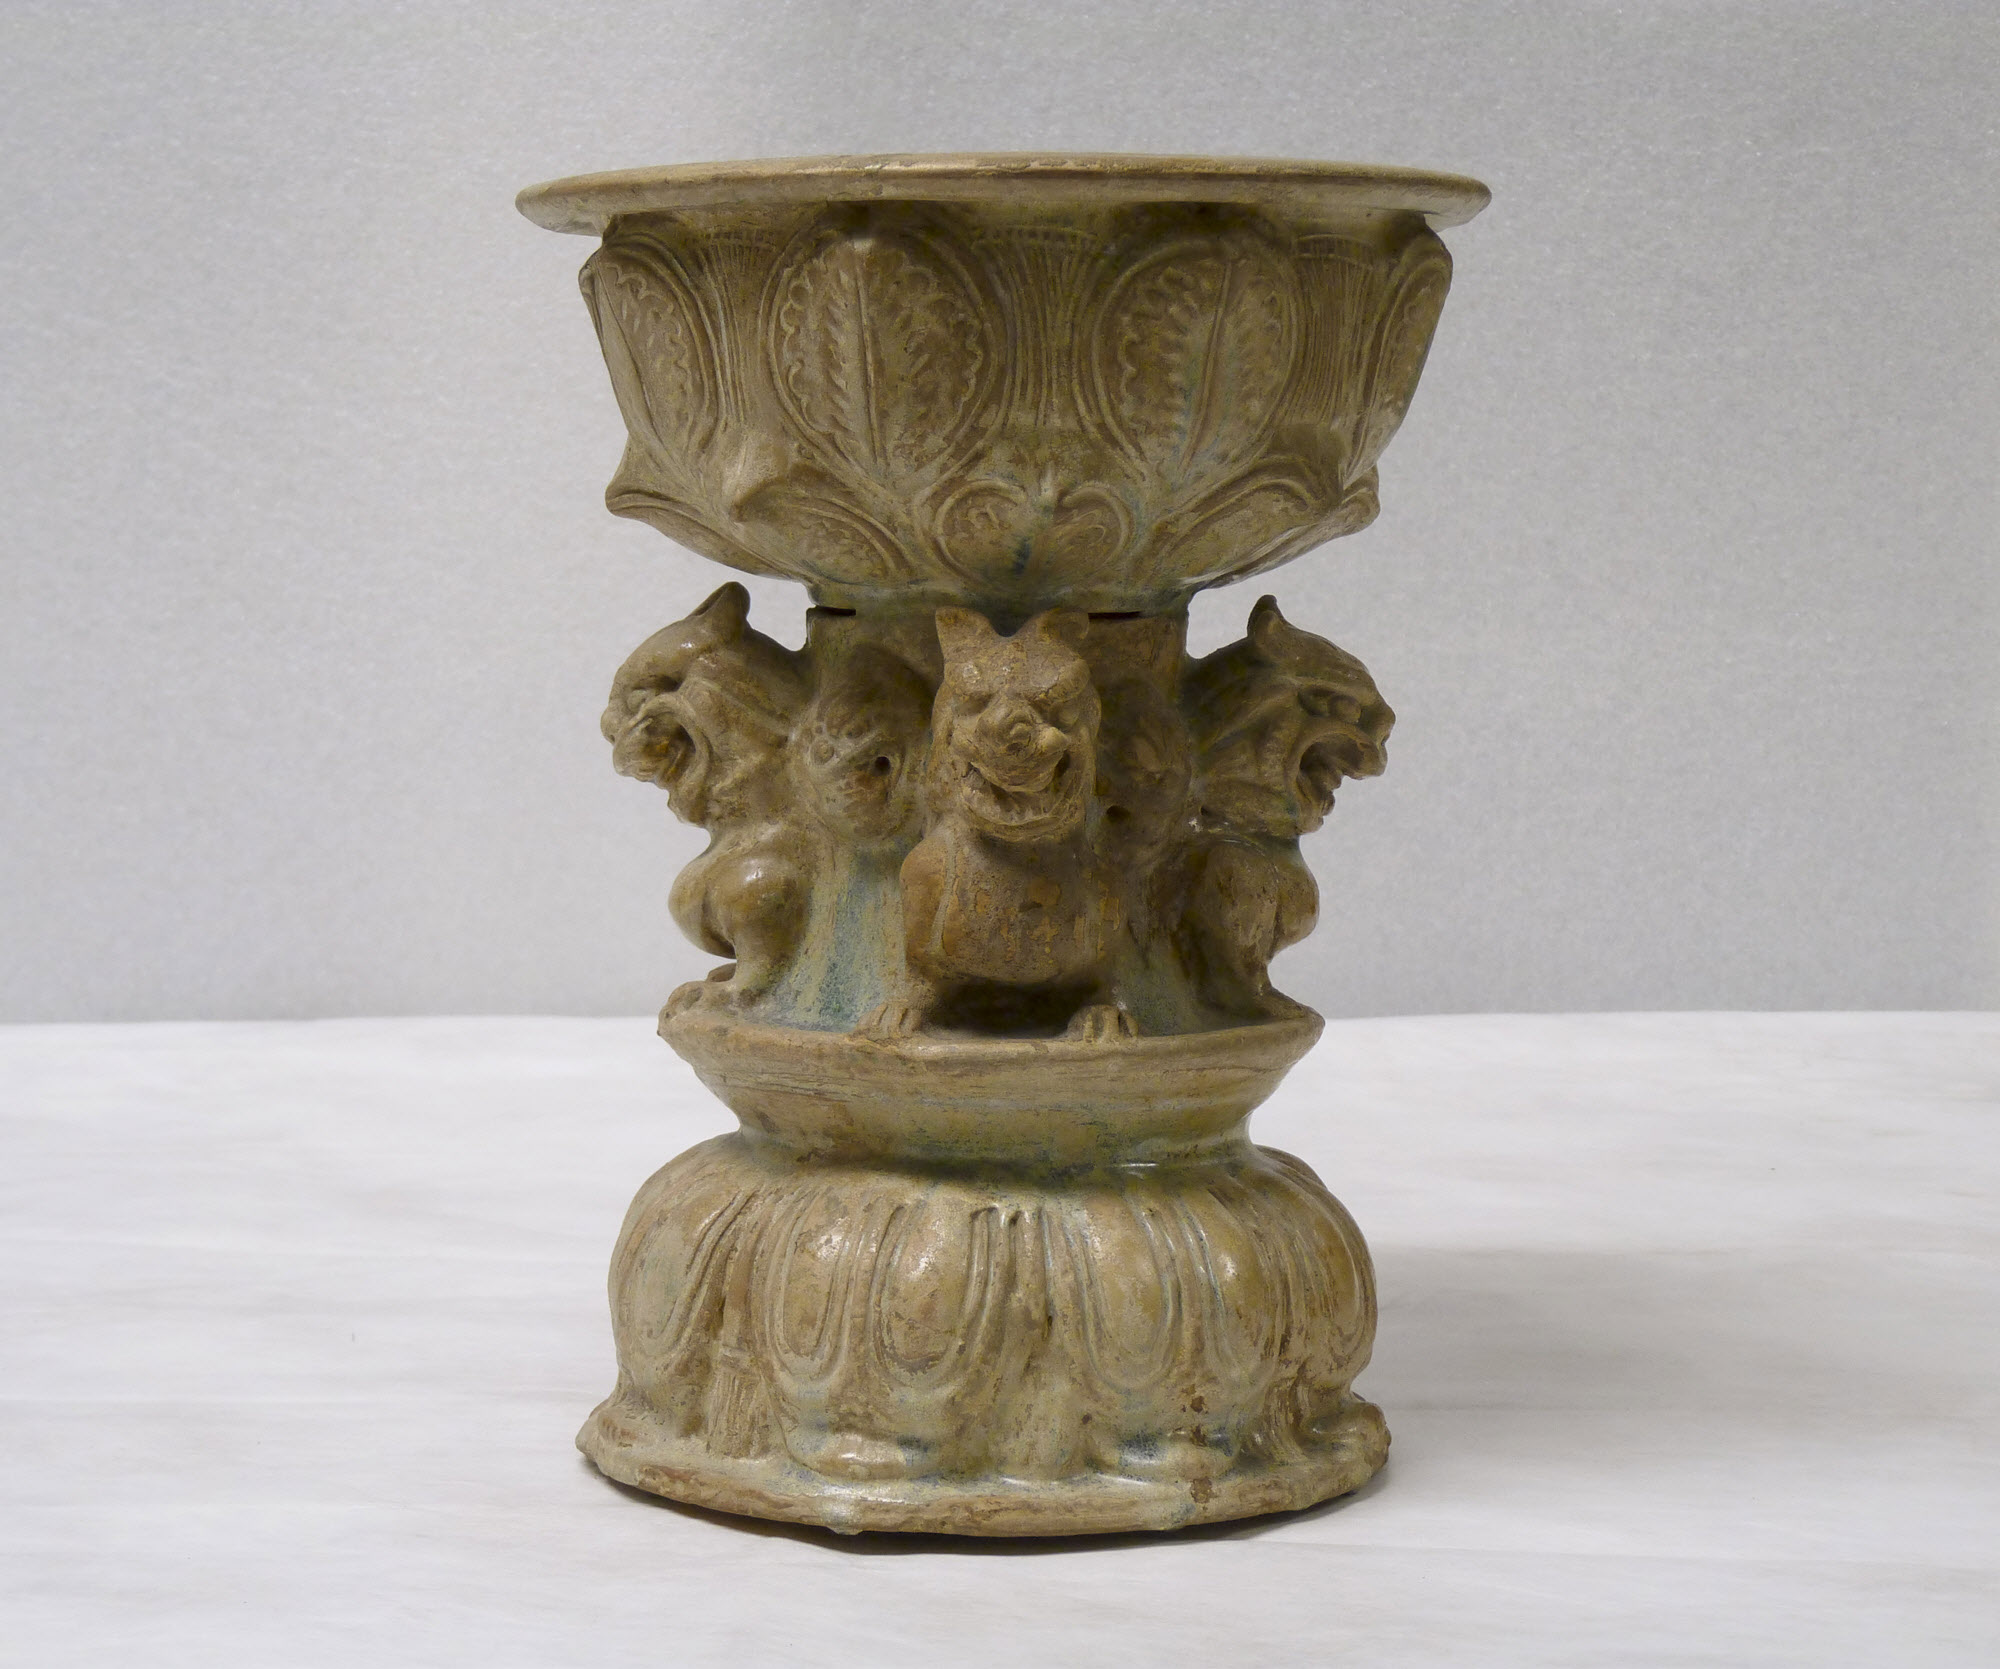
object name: lamp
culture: chinese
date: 551-600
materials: earthenware, glaze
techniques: relief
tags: lions